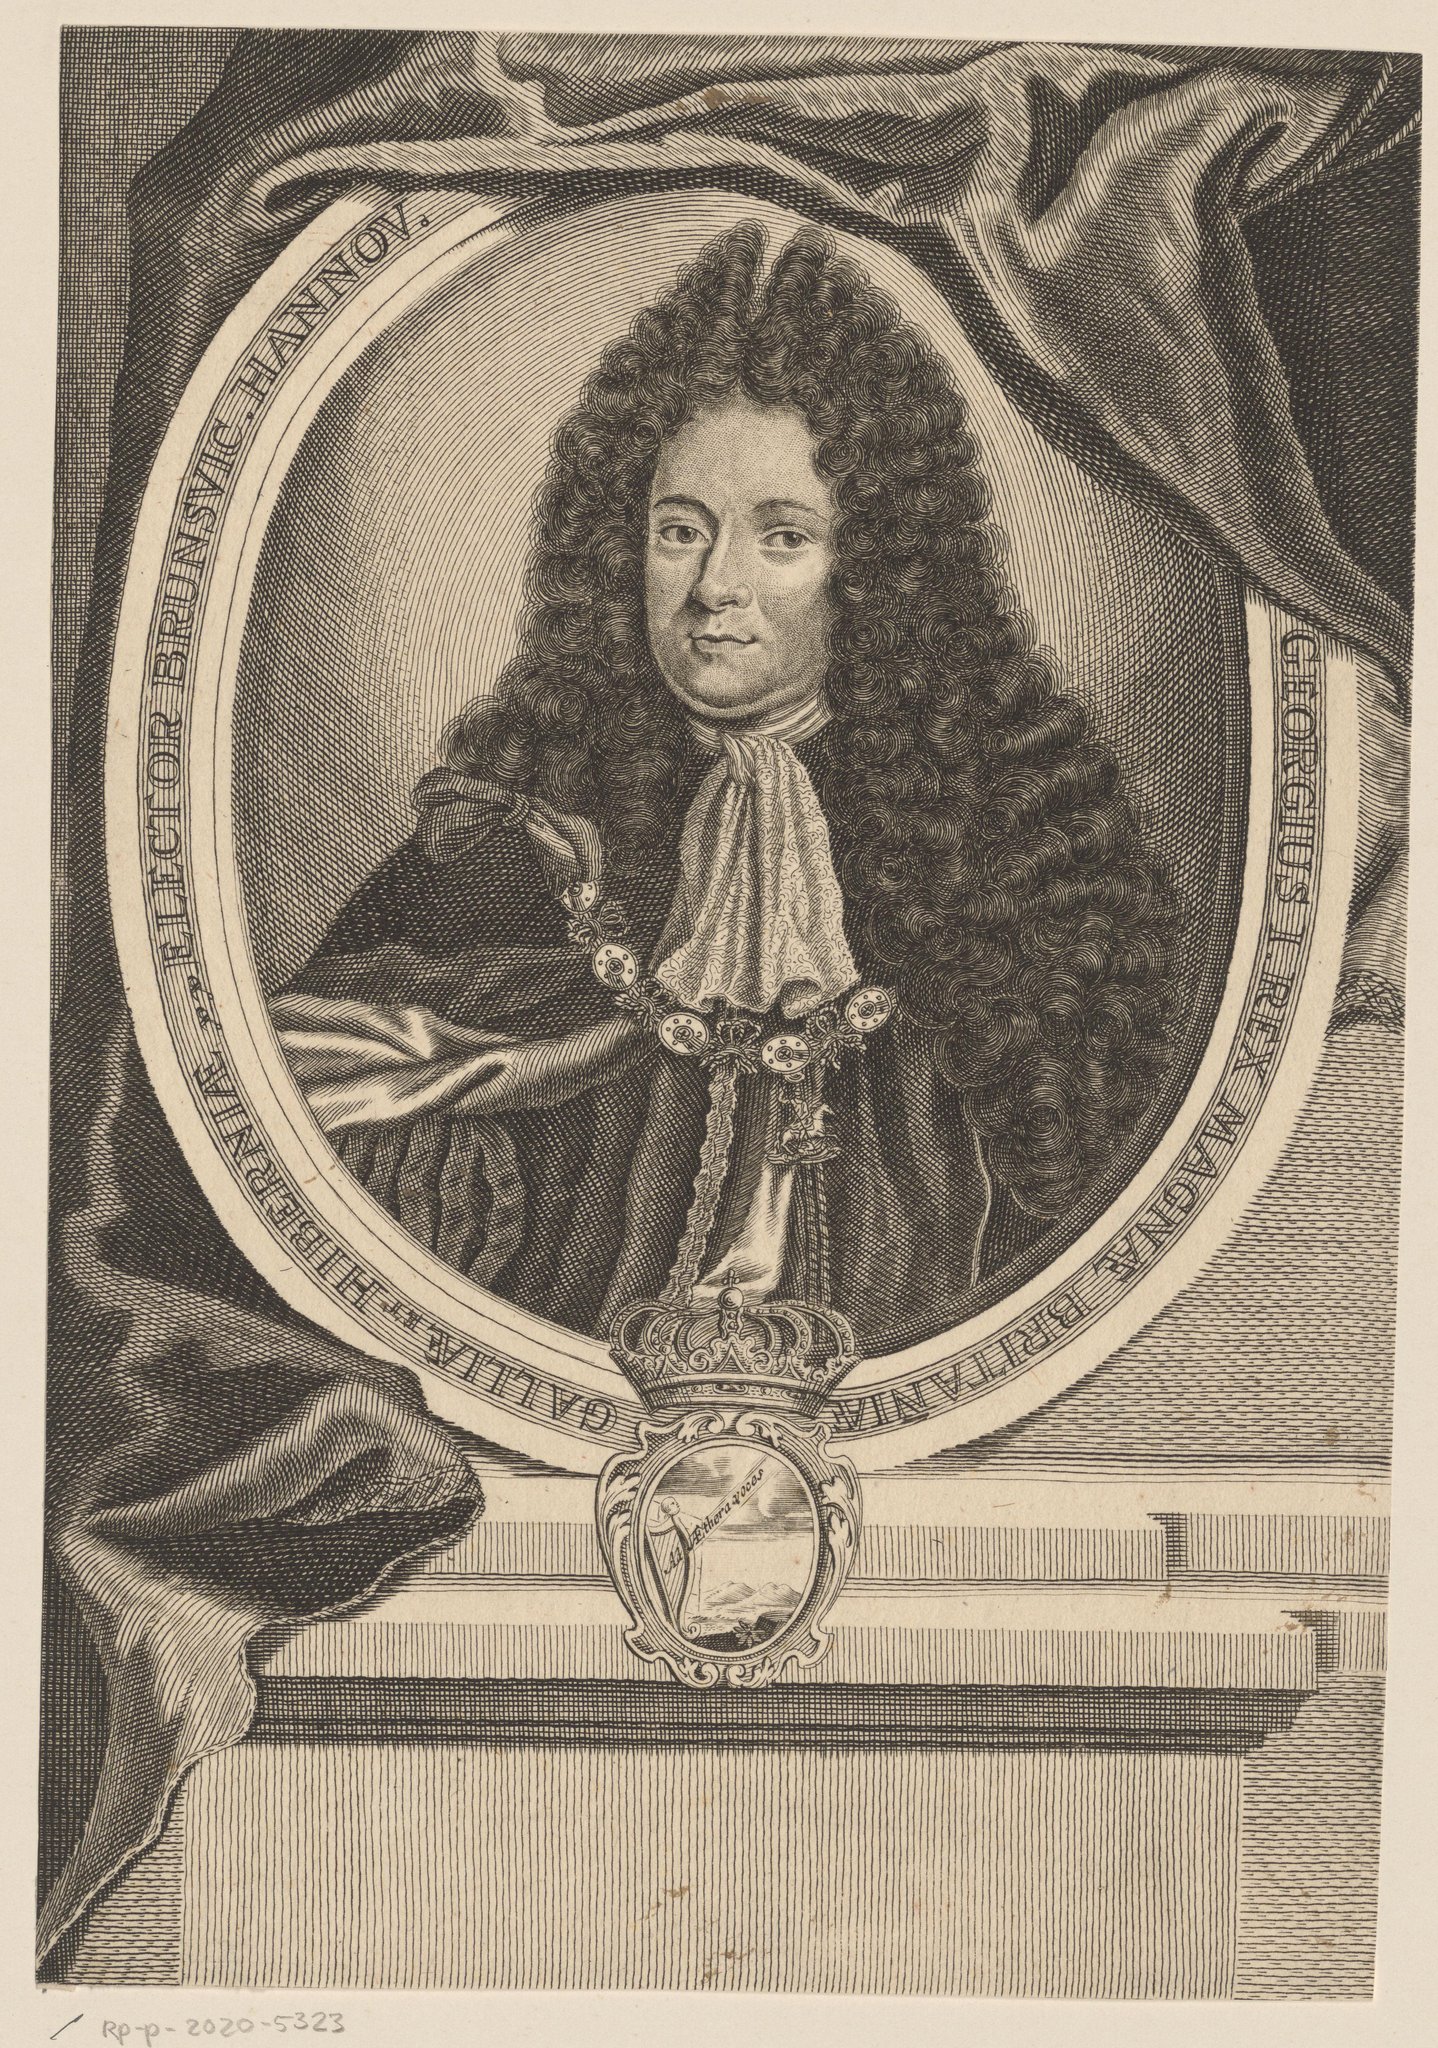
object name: print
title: Portret van George I, koning van Groot-Brittannië en Ierland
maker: Anonymous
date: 1698-1727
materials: paper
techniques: engraving, etching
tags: george i (koning van groot-brittannië en ierland), historical persons, king